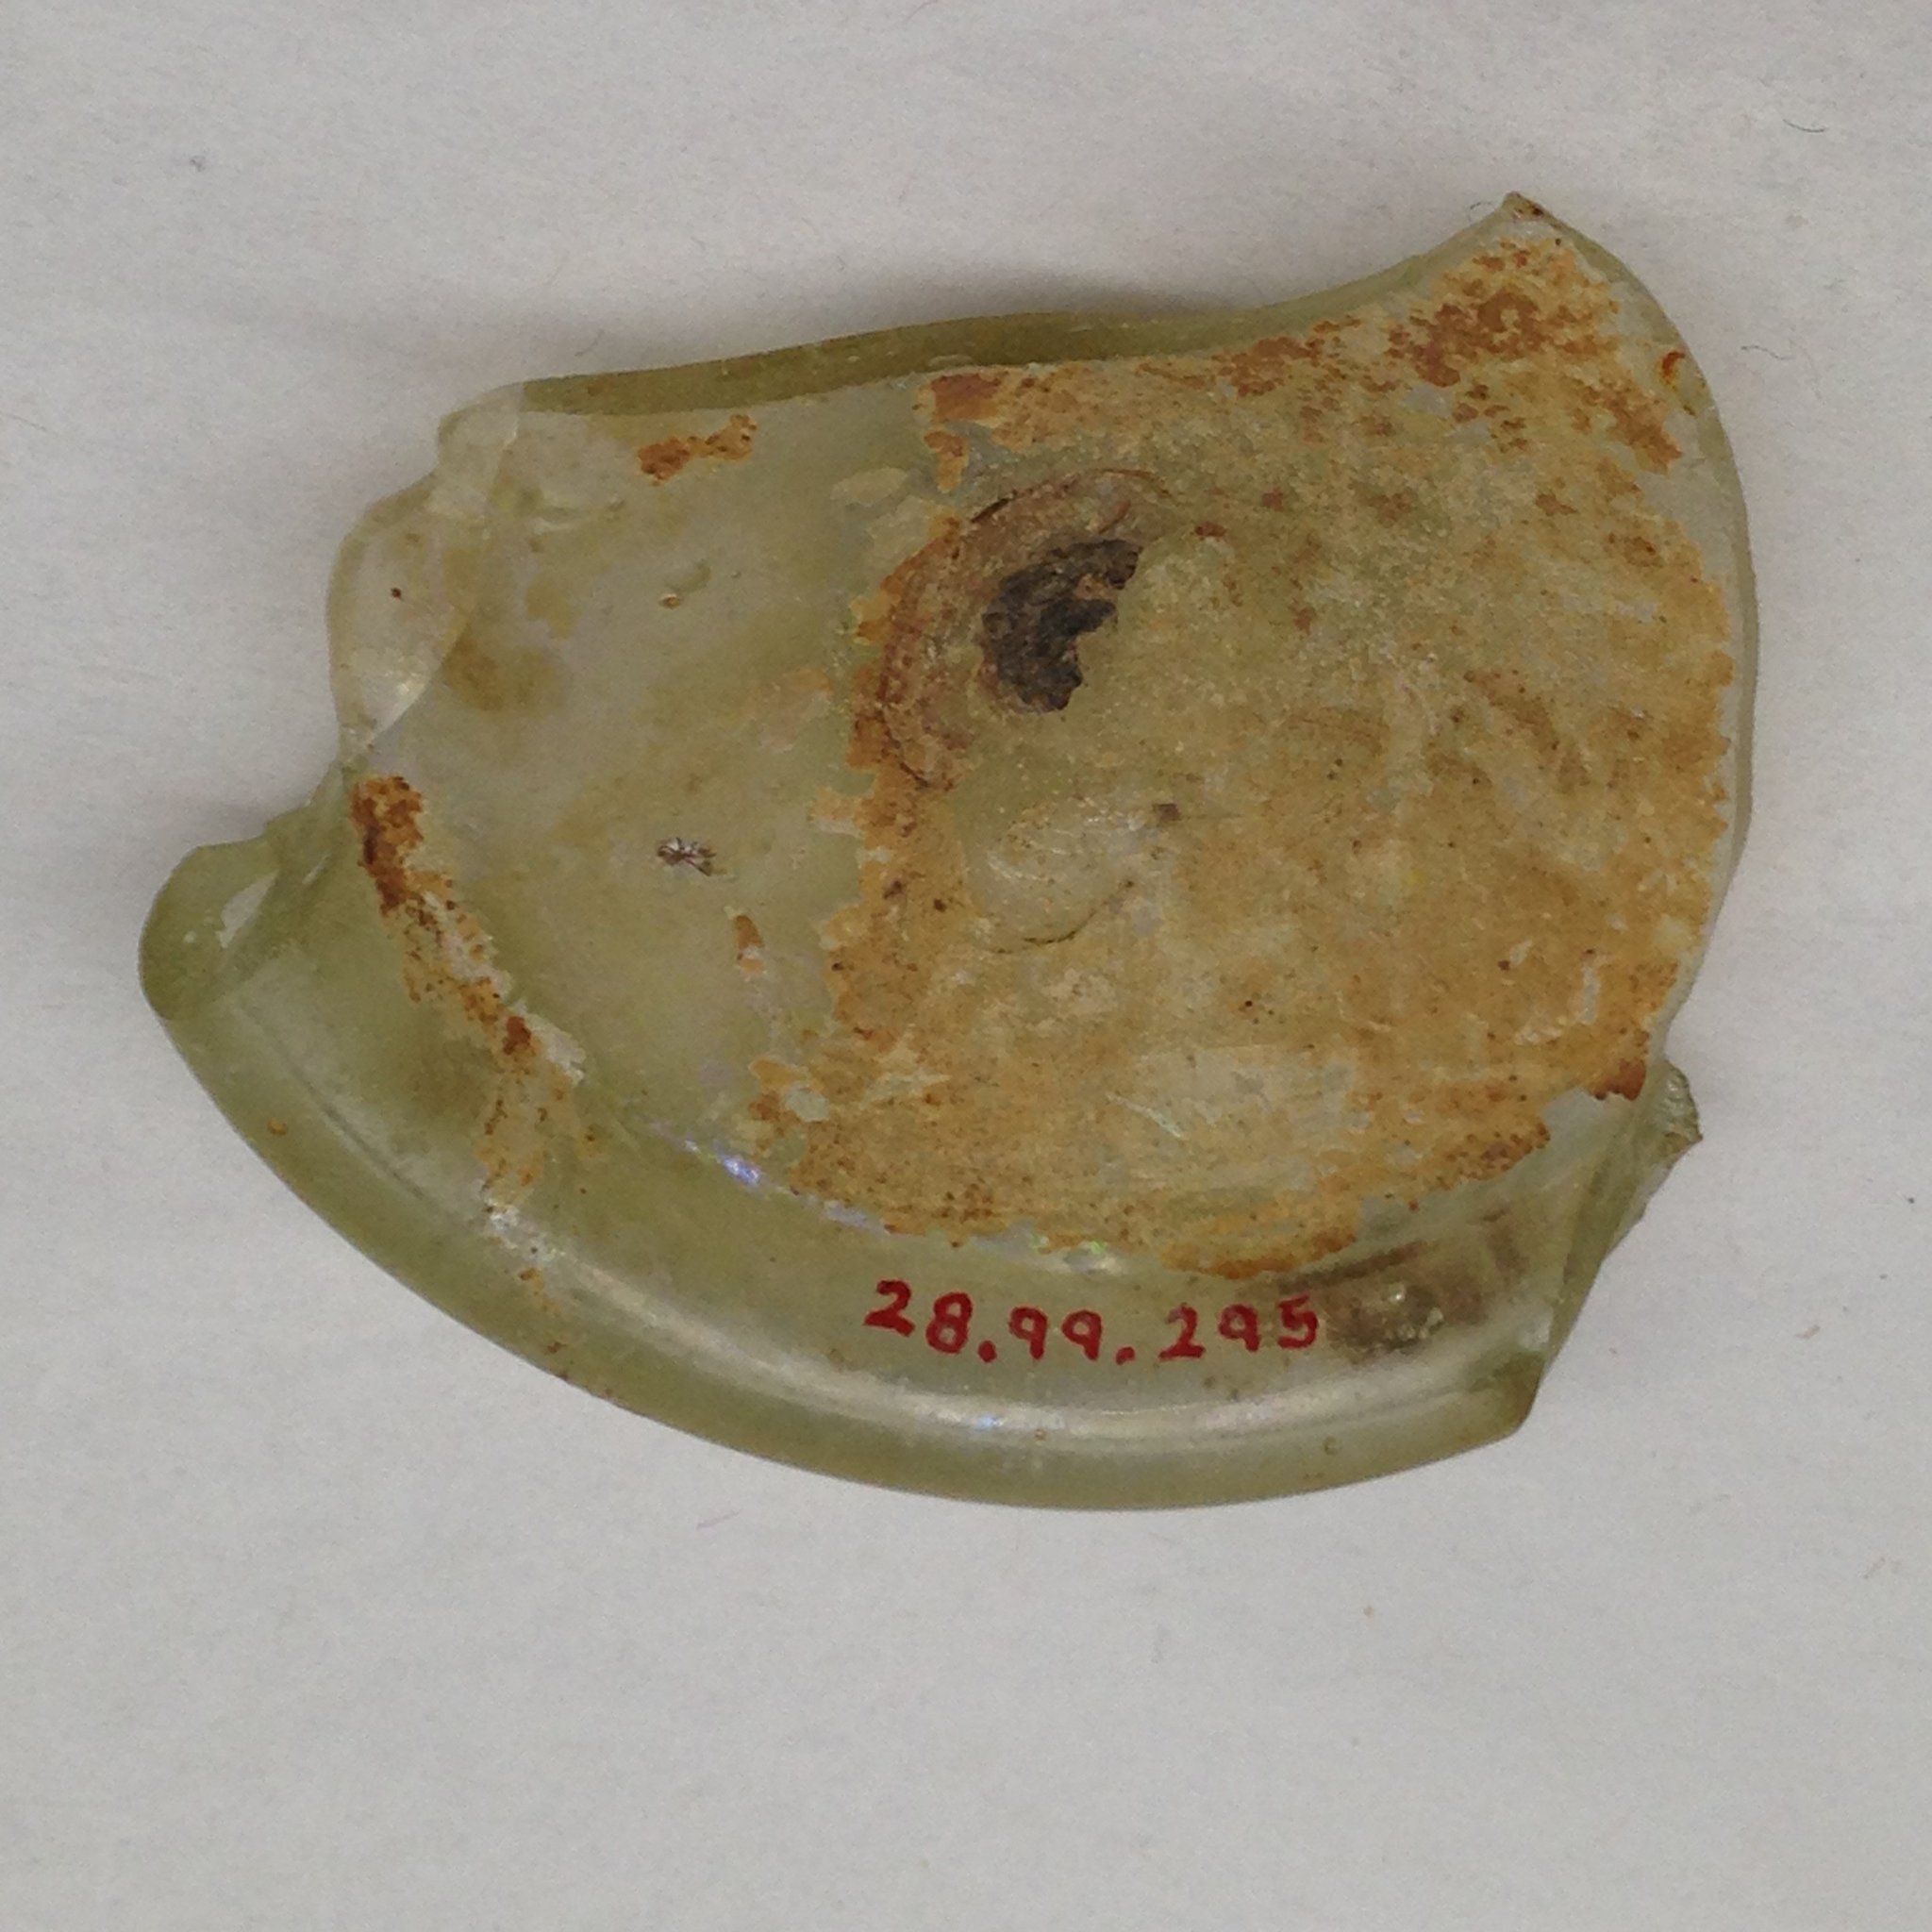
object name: fragment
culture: european or middle eastern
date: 1150-1250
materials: ceramic, glass